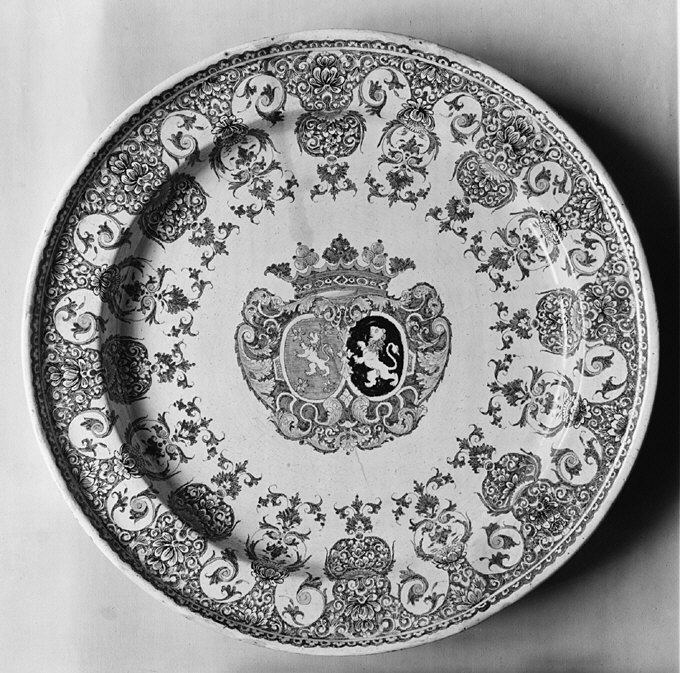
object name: plateau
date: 1705-1720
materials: faience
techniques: glazing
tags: coat of arms